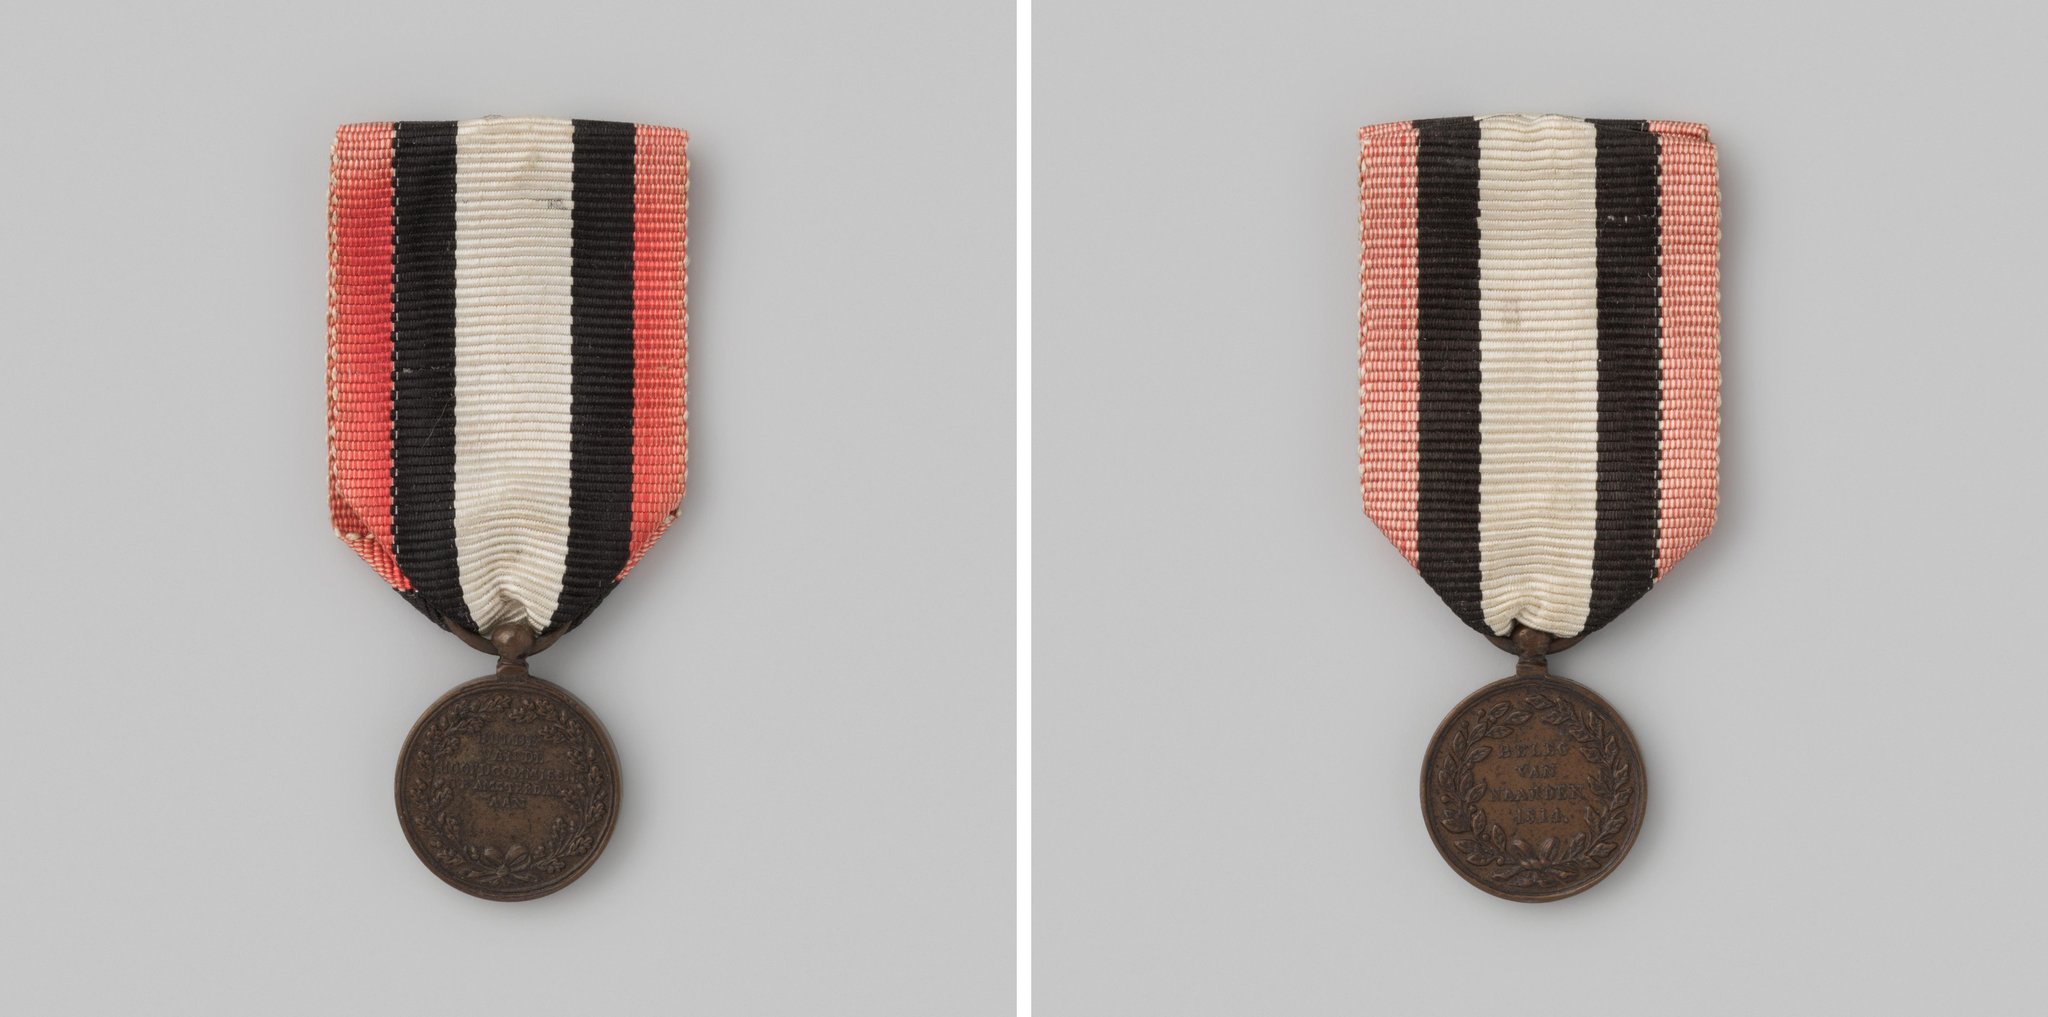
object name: insignia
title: Erepenning voor de schutters bij het beleg van Naarden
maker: hendrik de heus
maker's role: medailleur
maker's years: -1838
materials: bronze, textile